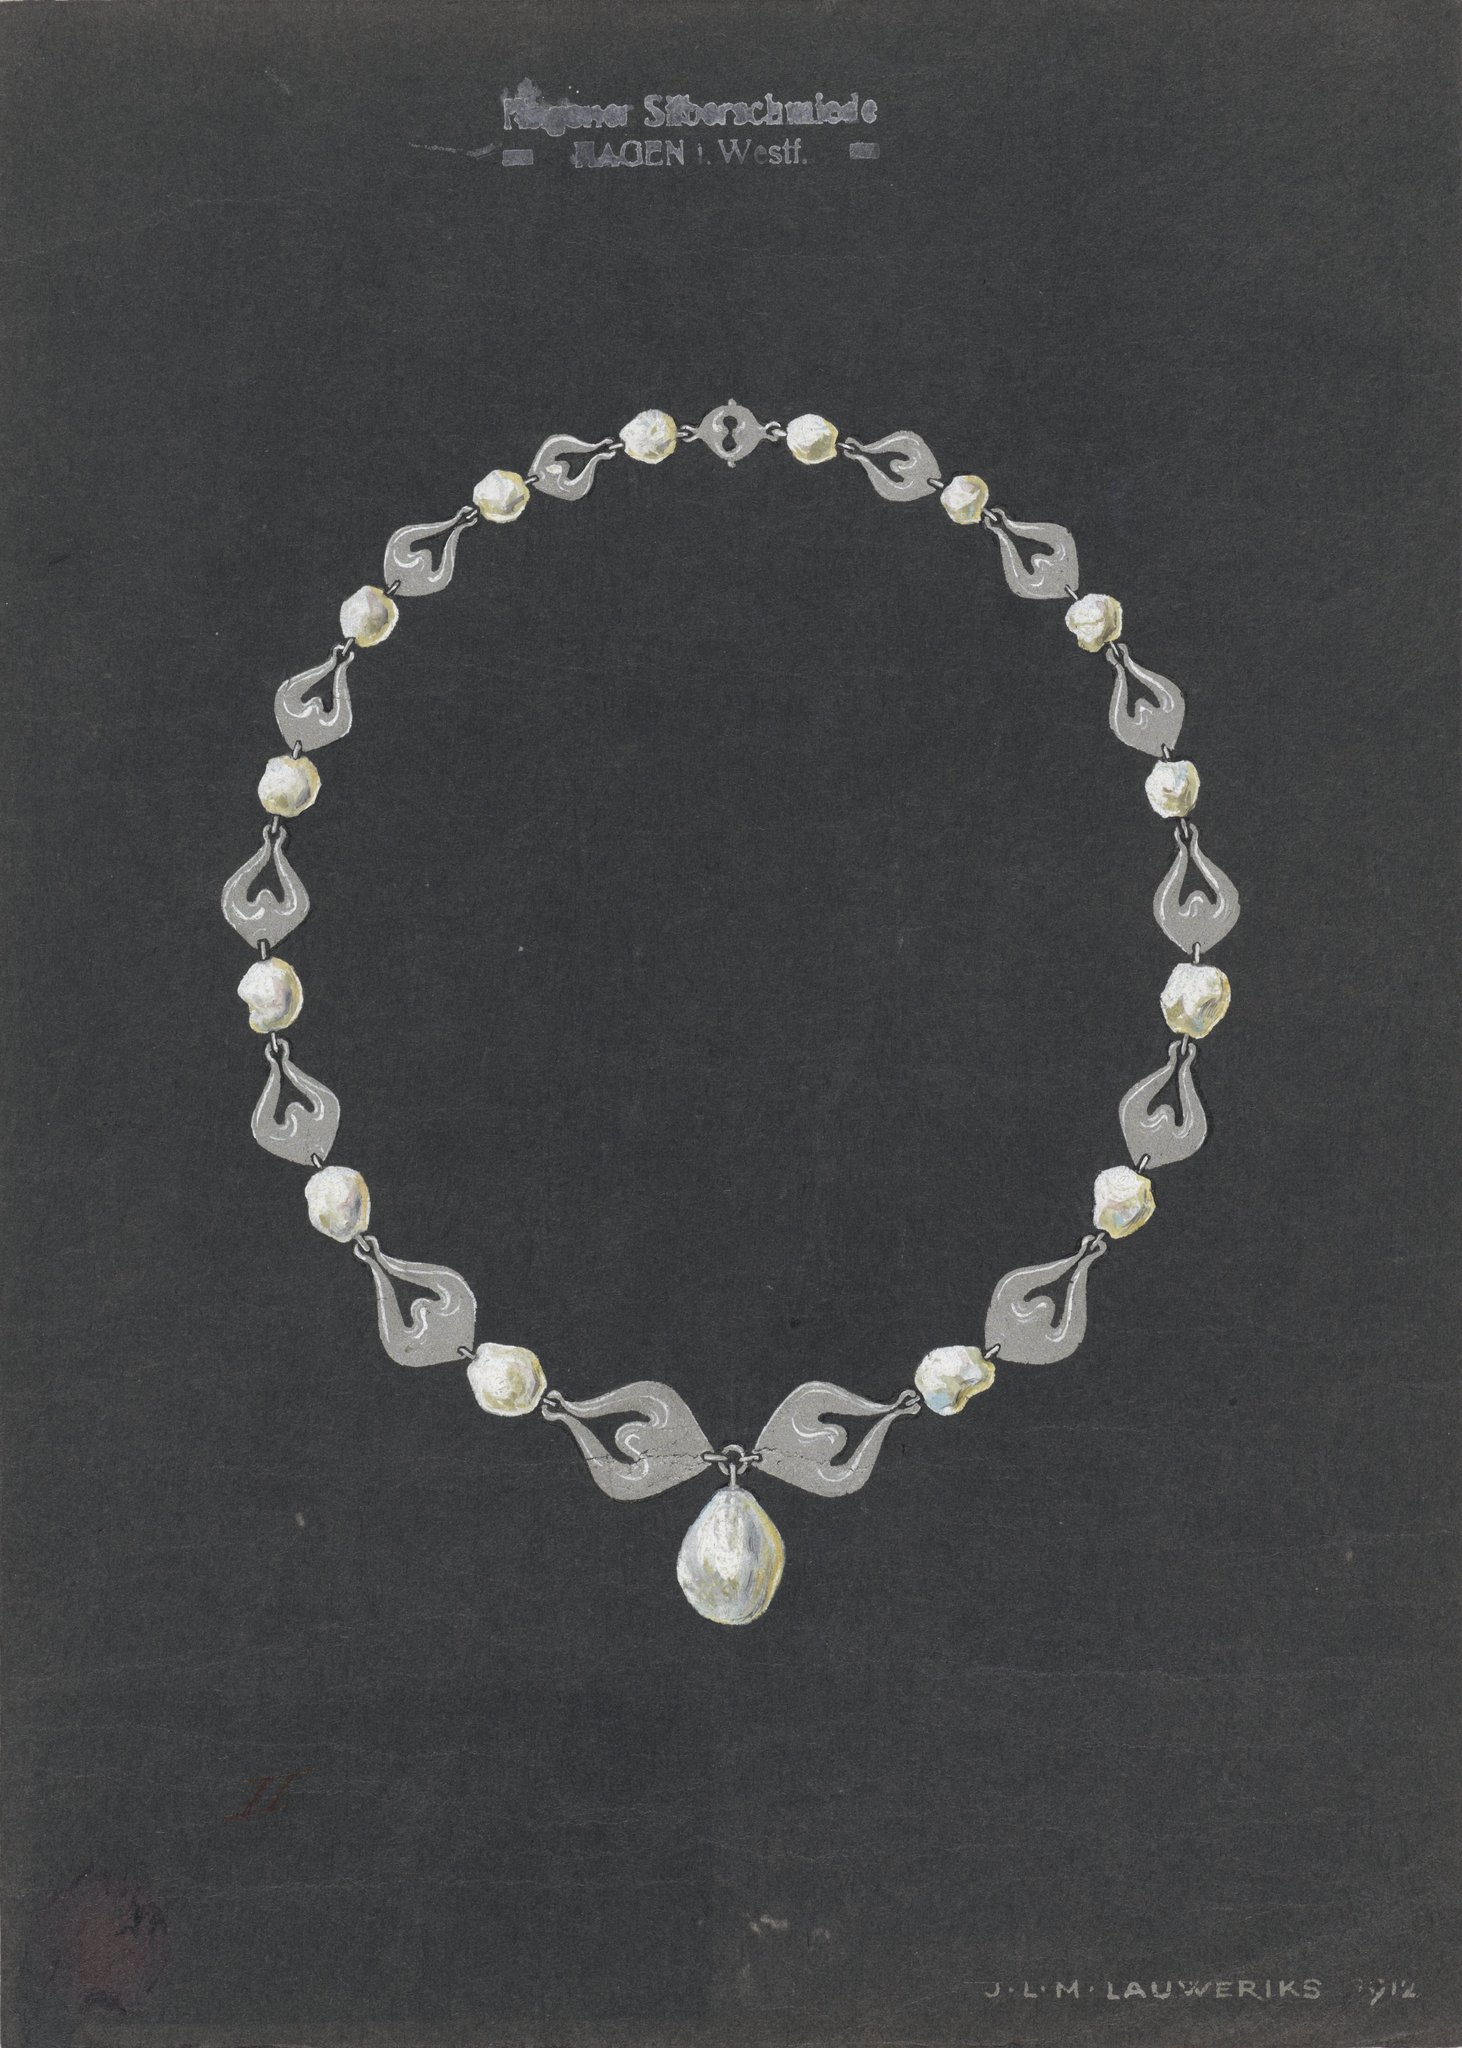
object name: design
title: Design for a Necklace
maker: mathieu lauweriks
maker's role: designer, draughtsman, print maker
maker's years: 1864-1932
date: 1912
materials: paint, paper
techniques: brush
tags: necklace (+ women's clothes)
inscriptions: date: ‘1912’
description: This is one of the few presentation drawings from the estates of Lauweriks and Zwollo. It features a fully developed design of a necklace against a black background. Large jewellery houses still commission drawings like this for new collections, partly to show to customers but also to create an archival record of the jewels they have made.